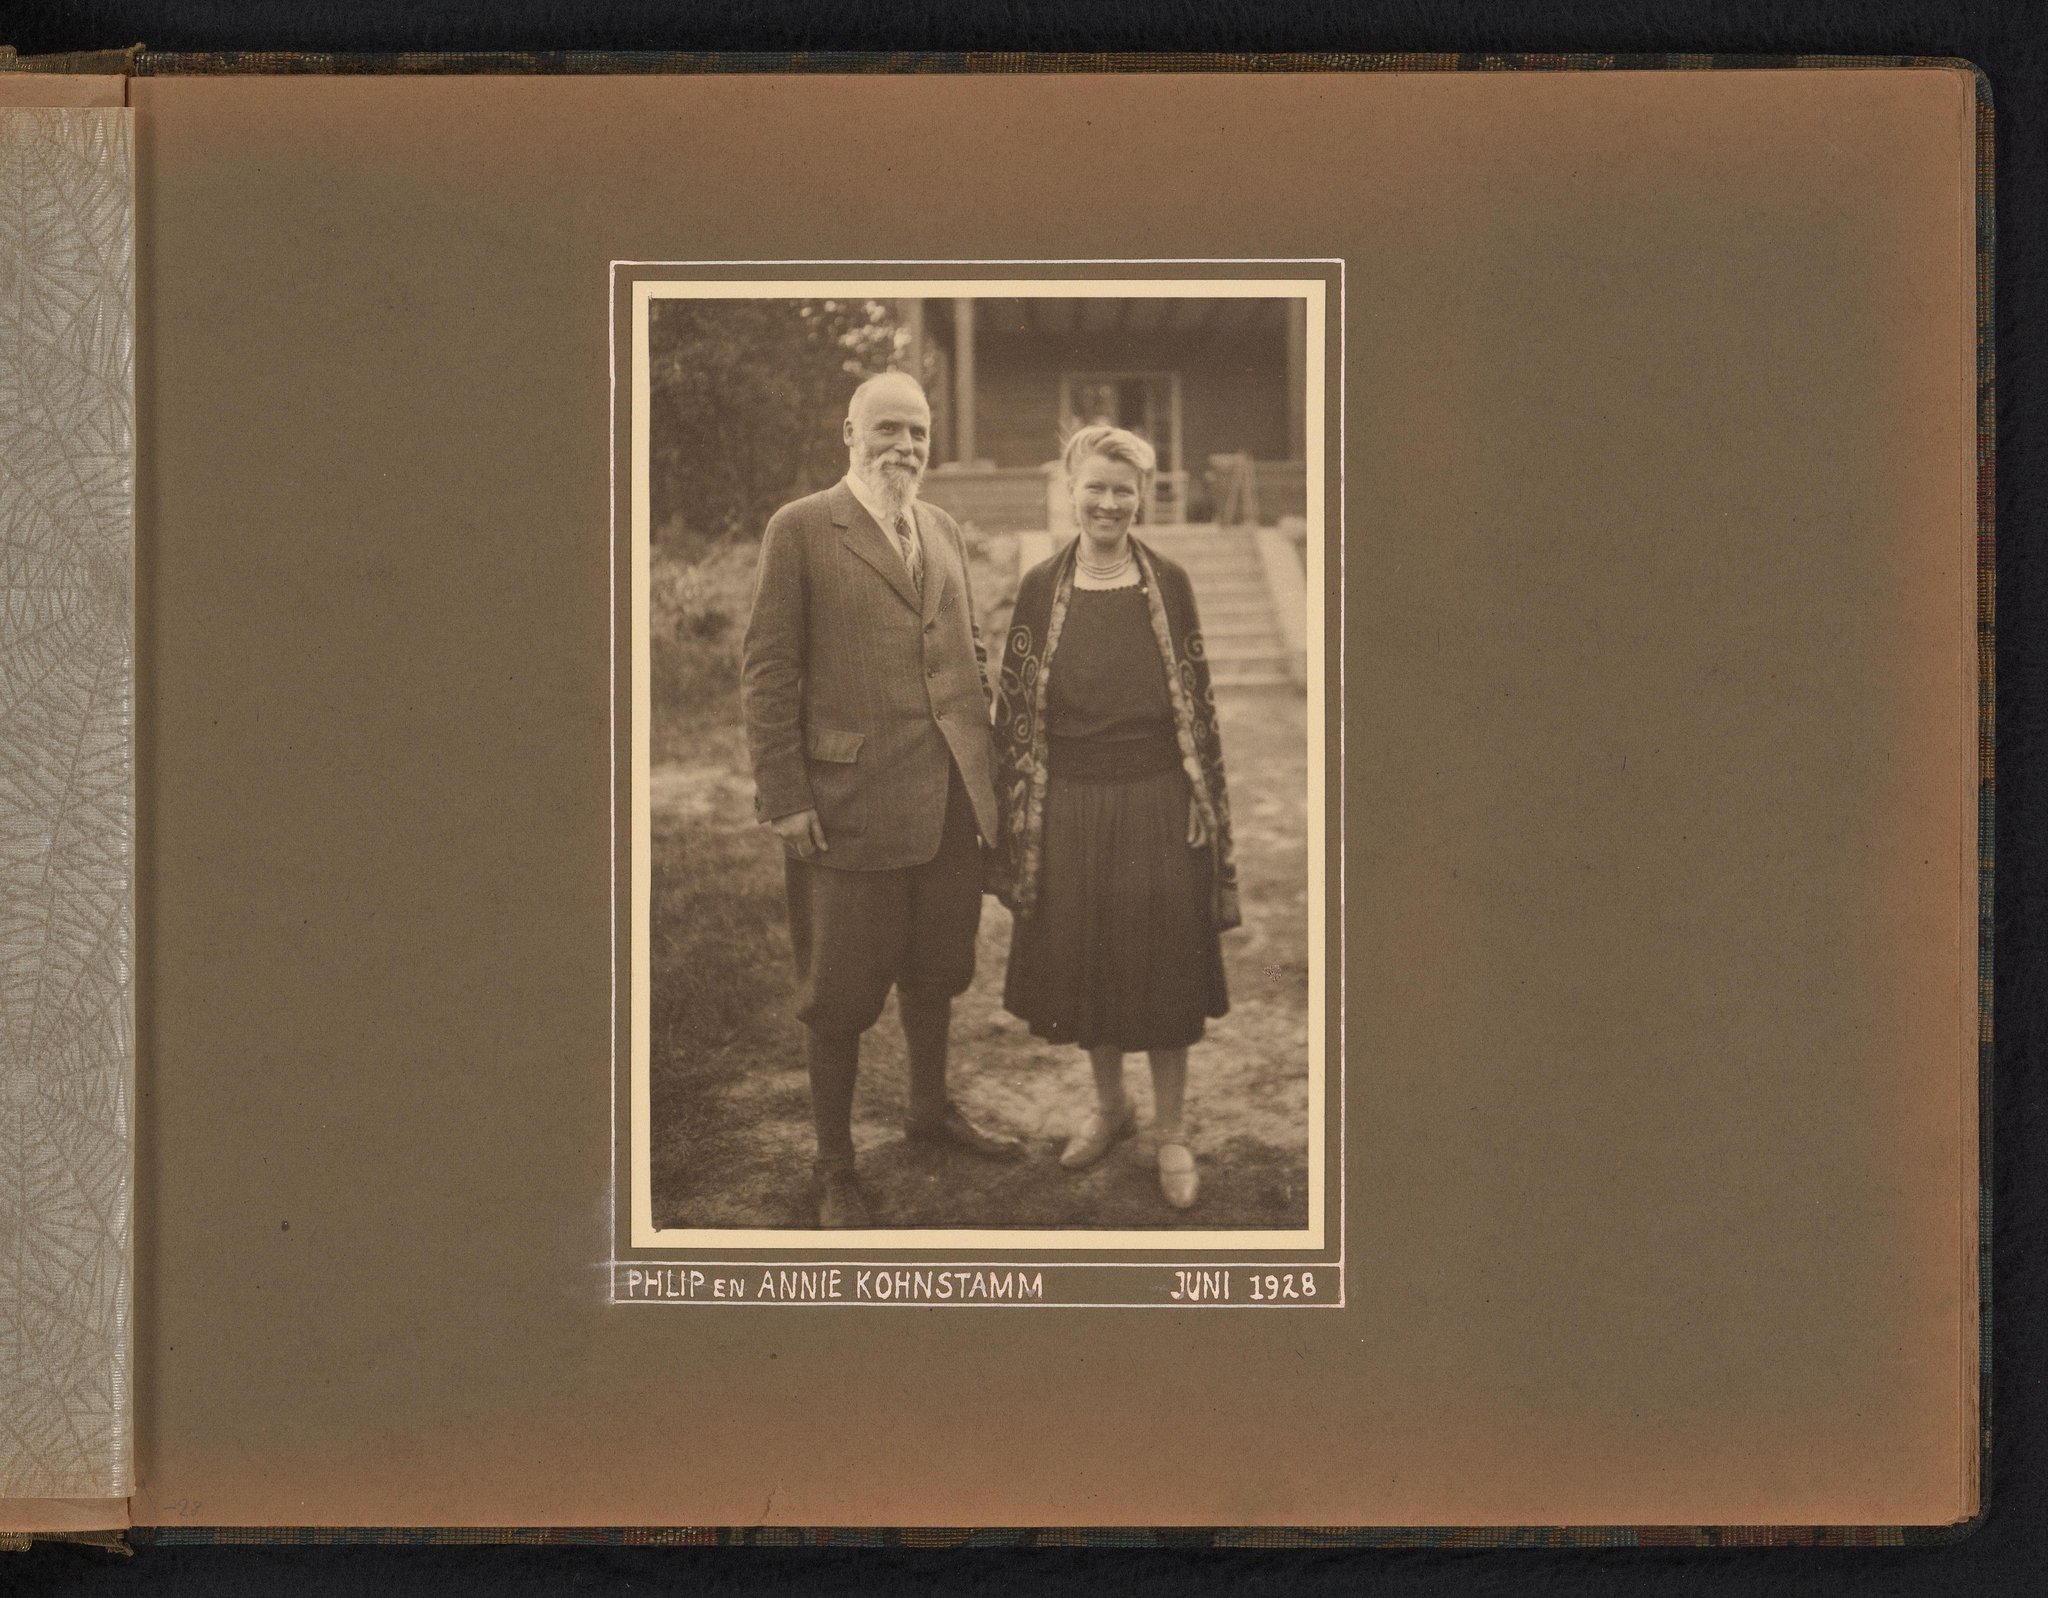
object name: photograph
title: Philip en Annie Kohnstamm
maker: Anonymous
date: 1906-1928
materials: paper, cardboard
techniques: gelatin silver print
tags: physicist, historical persons